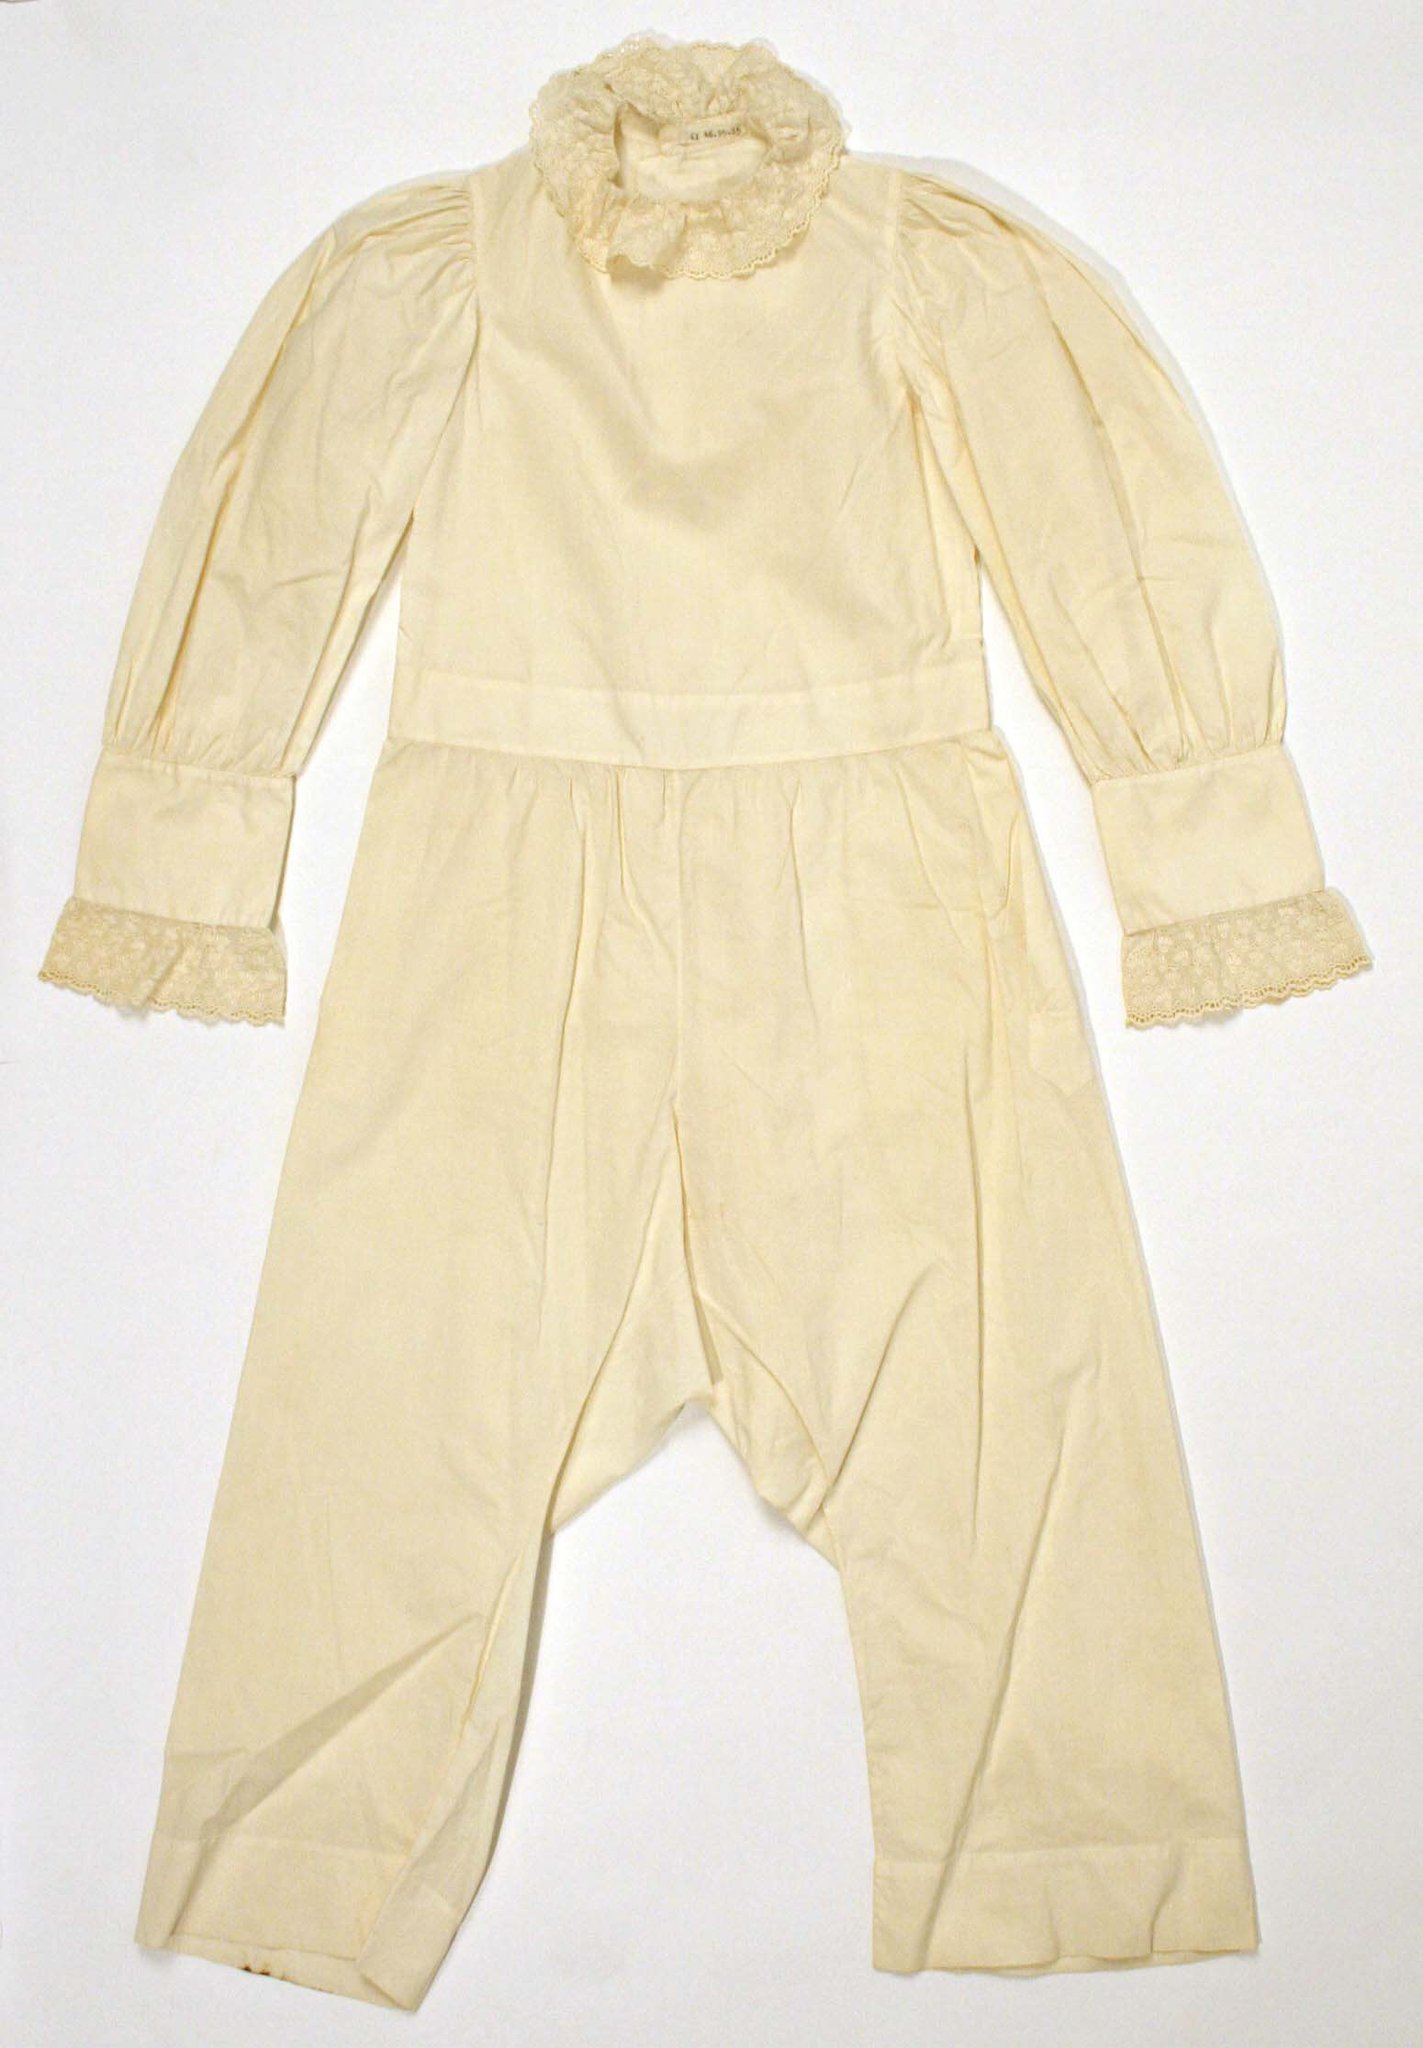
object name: combination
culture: american or european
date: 1890